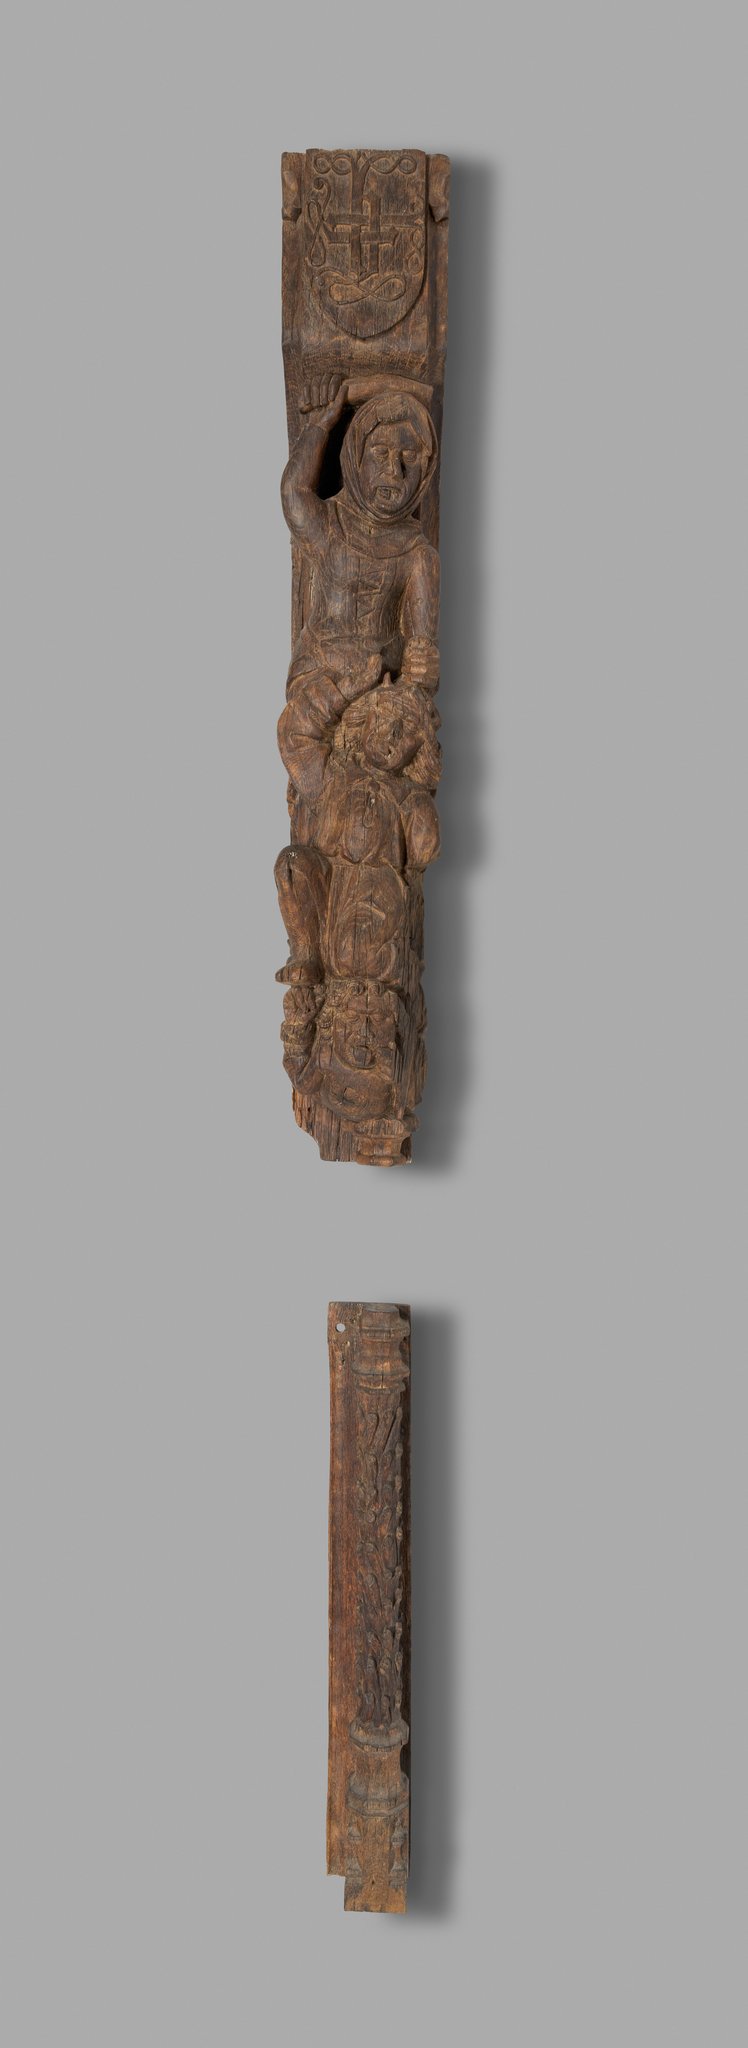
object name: support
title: Architectural Support with Quarreling Figures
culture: french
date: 1524-1525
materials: wood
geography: england